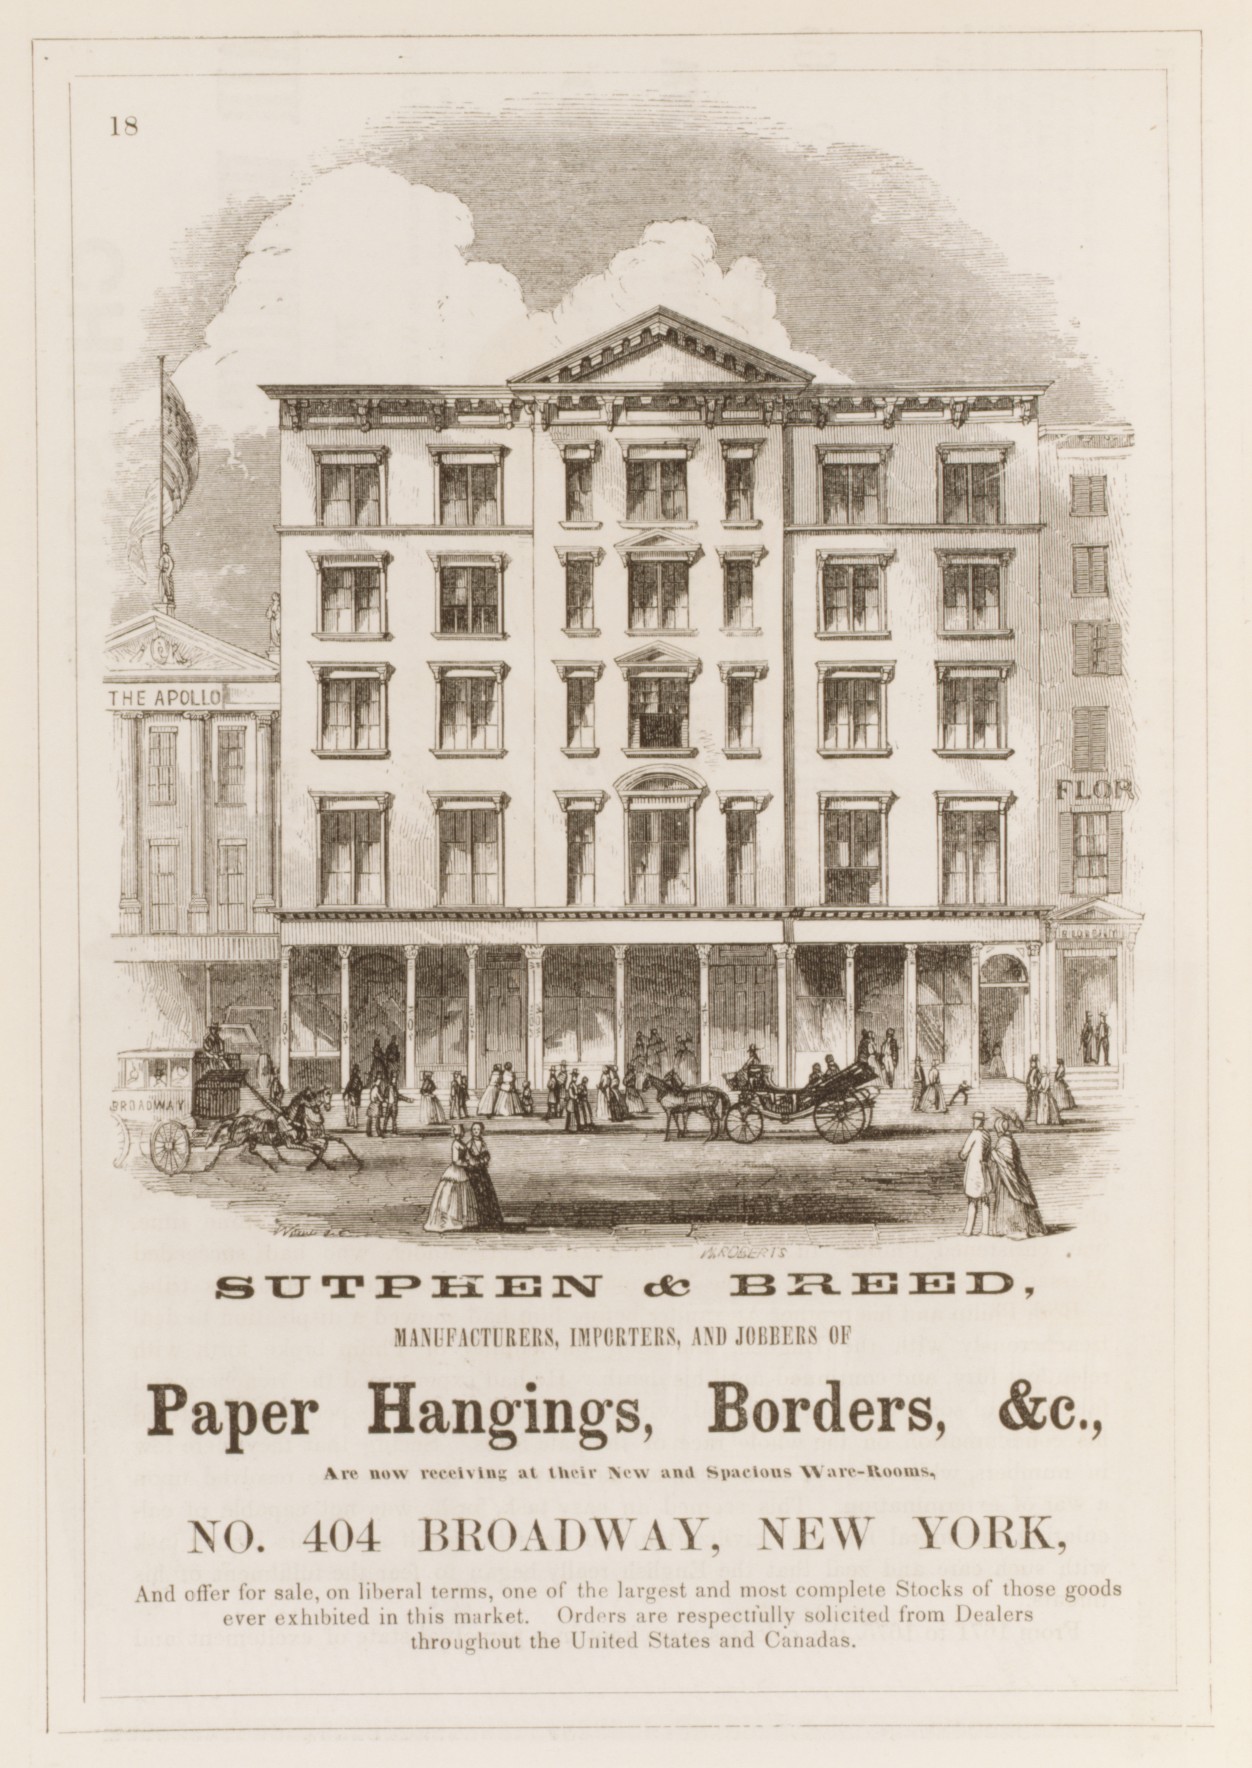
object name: book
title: The Illustrated American Biography; containing correct Portraits and Brief Notices of the Principal Actors in American History, embracing distinguished women, naval and military heroes, statesmen, civilians, jurists, divines authors and artists...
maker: abner dumont jones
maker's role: author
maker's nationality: american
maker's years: 1807-1872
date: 1855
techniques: engraving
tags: buildings,carriages